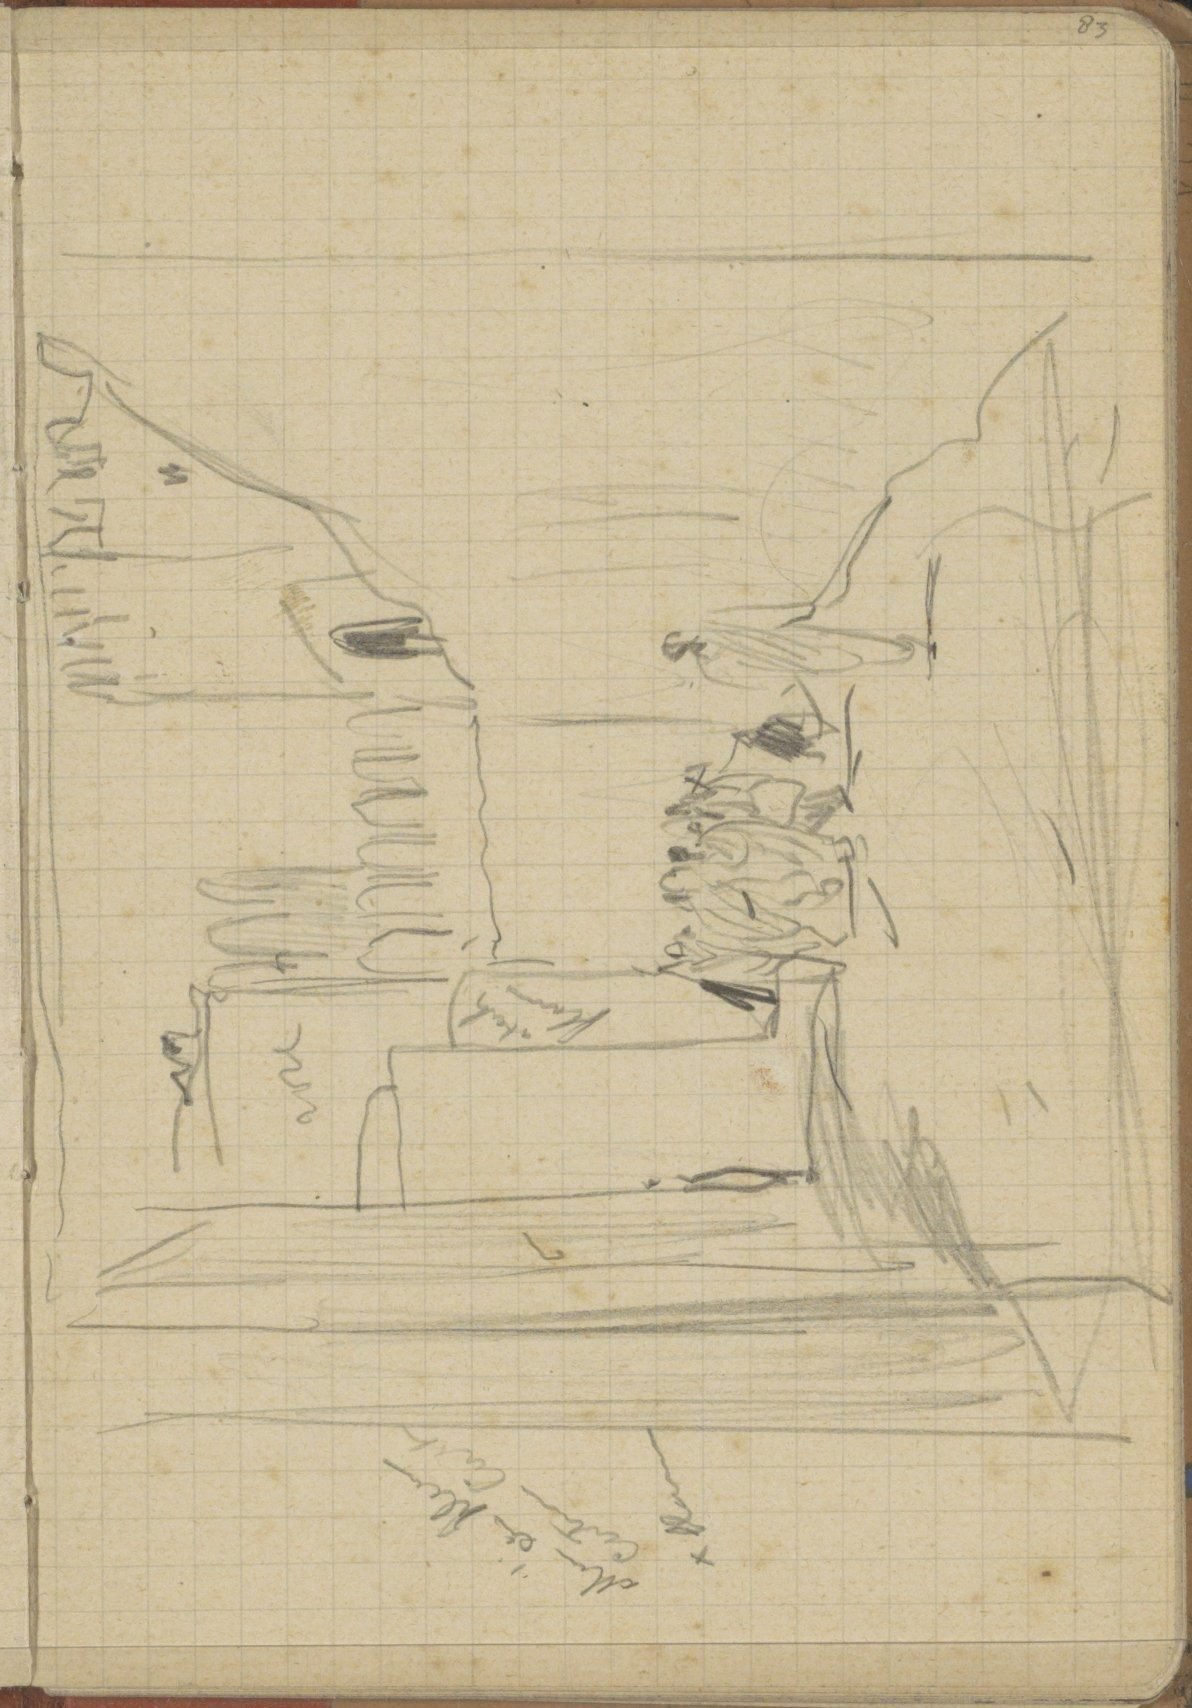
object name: sketchbook leaf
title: Straat met figuren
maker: marius bauer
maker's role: draughtsman, print maker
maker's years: 1867-1932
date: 1909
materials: pencil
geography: tunisia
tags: street (+ city(-scape) with figures, staffage)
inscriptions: kleurnotitie, handgeschreven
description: Pagina 83 uit een schetsboek met 67 bladen.